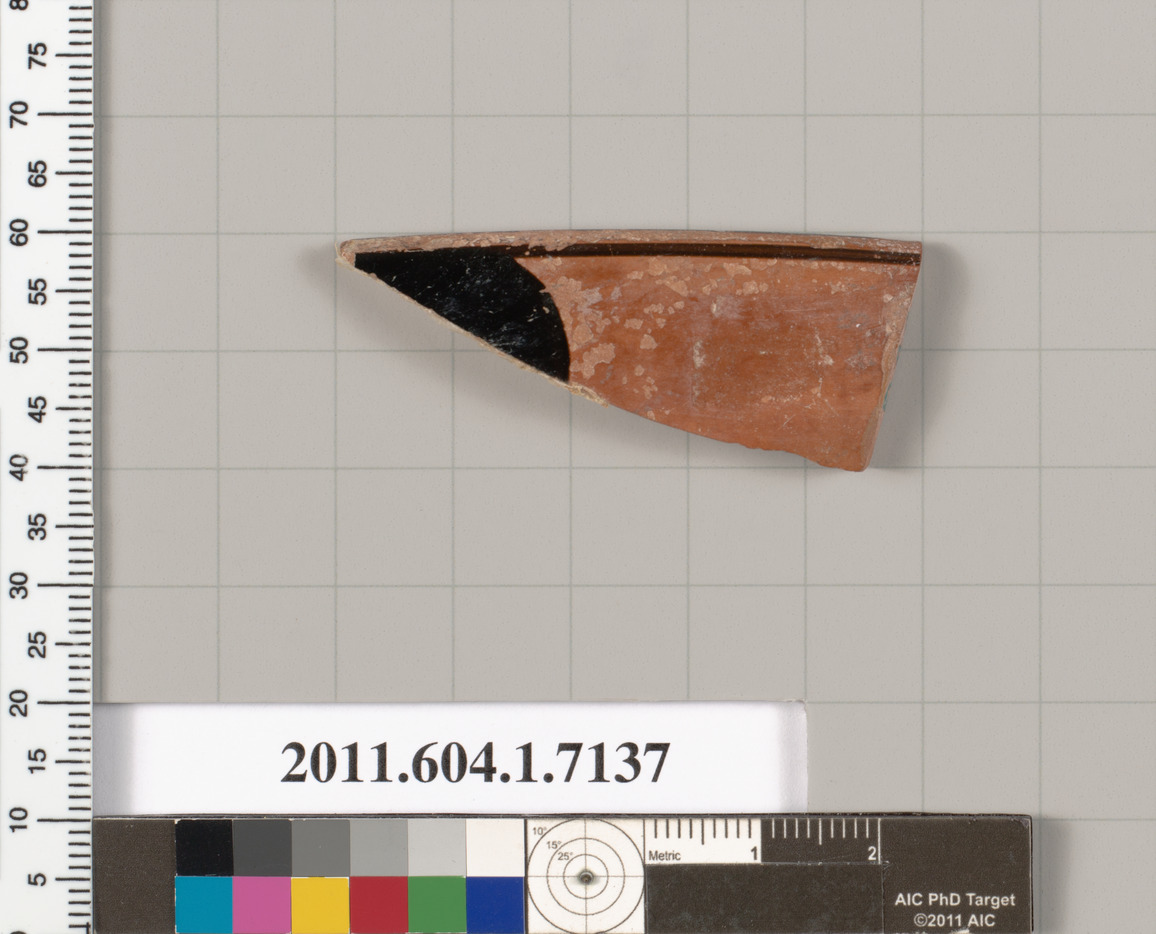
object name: kylix fragment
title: Terracotta fragment of a kylix (drinking cup)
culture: greek, attic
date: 500-480 BCE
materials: terracotta